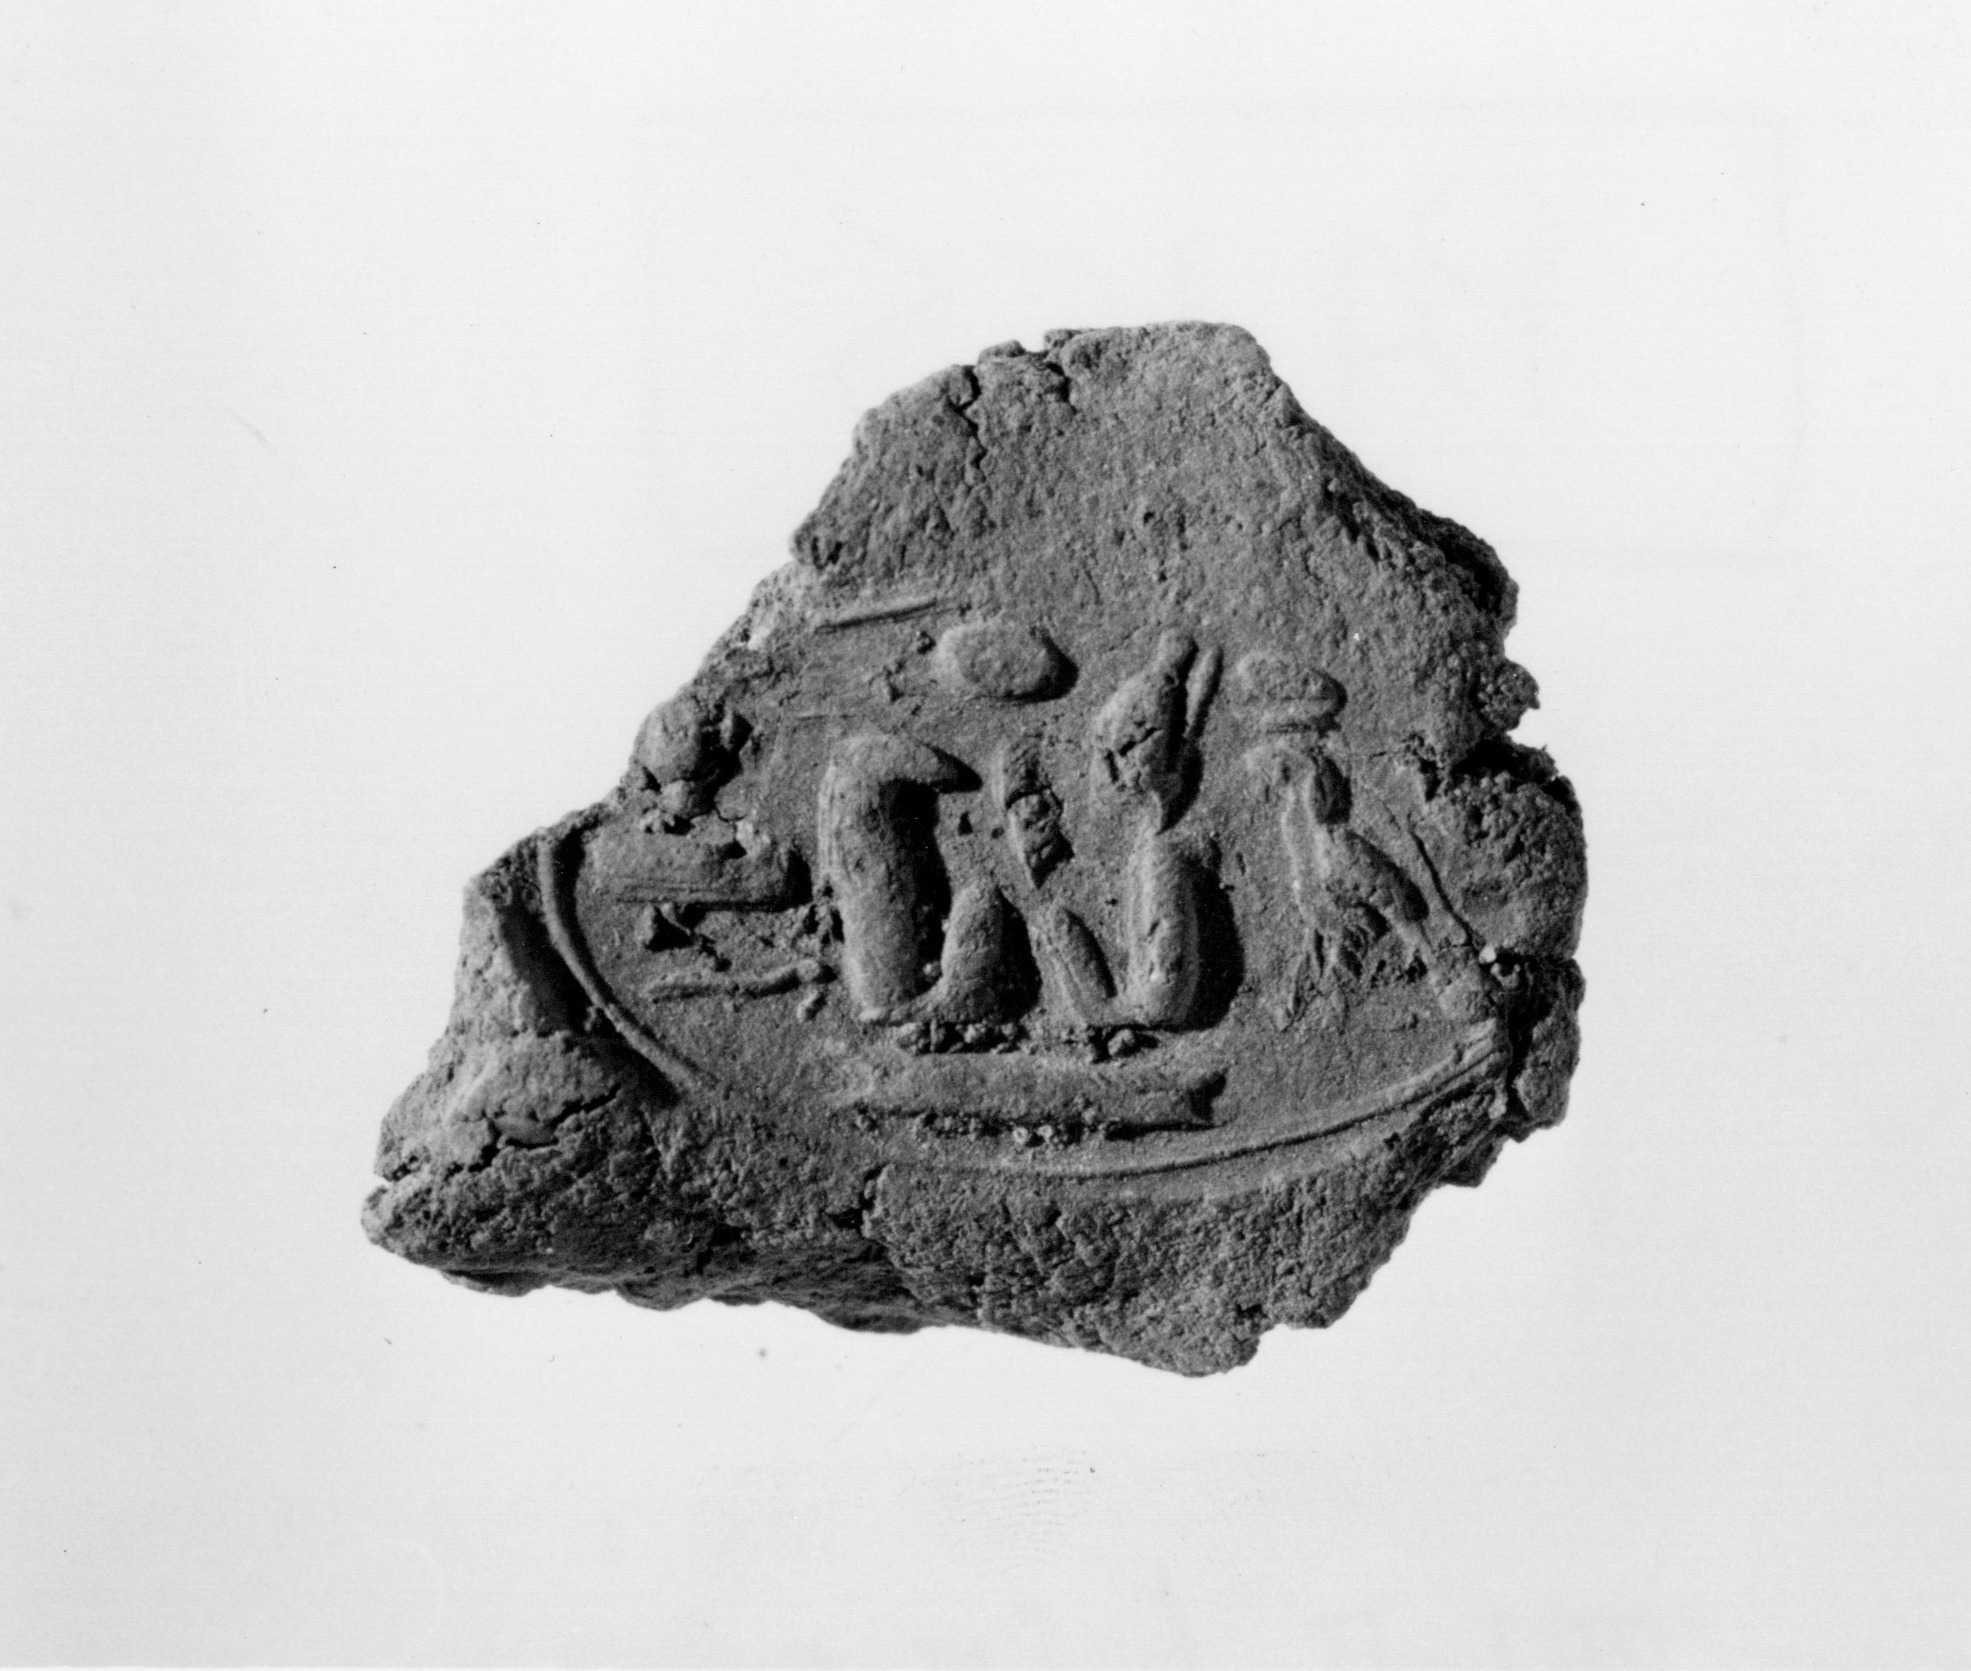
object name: sealing, nebmaatre, amenhotep iii, horus, re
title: Document Sealing With the Throne Name of Amenhotep III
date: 1390-1352 BCE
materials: mud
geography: egypt